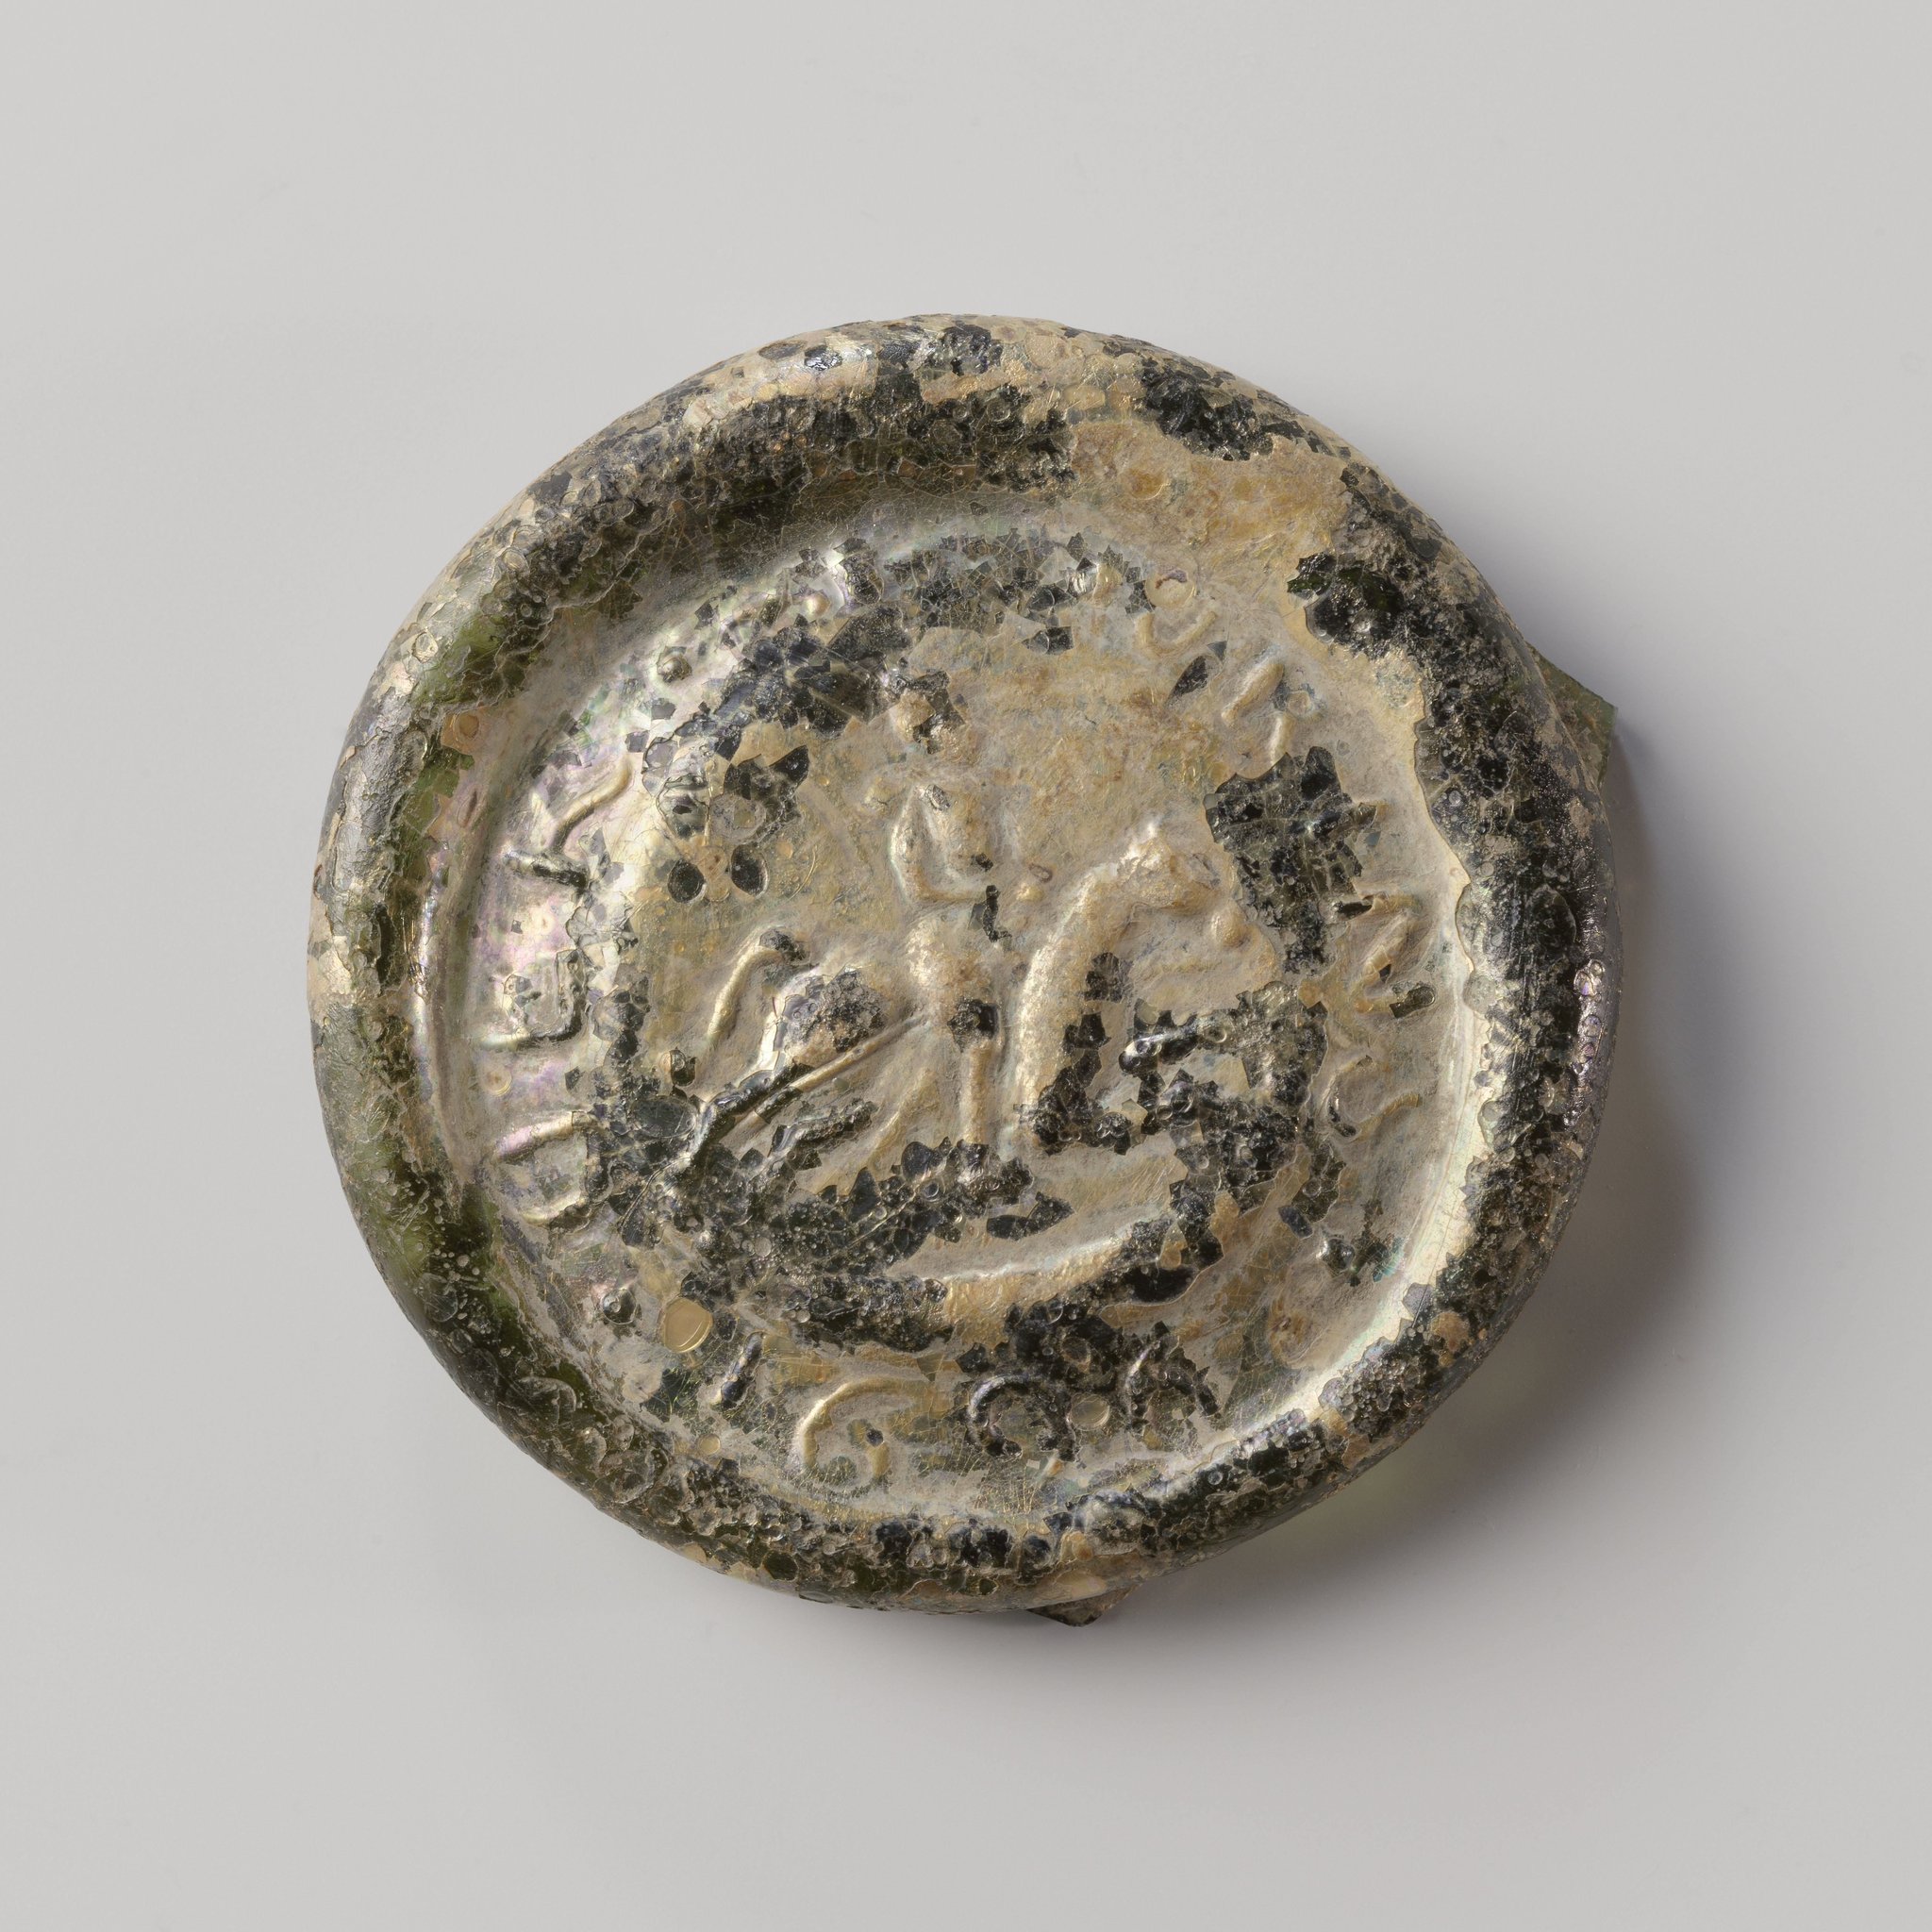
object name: glaszegel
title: Glaszegel van een fles met het ruiterportret van Willem III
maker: Anonymous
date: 1696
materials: glass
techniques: glassblowing, printing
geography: holstein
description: Orange souvenirs. William III's popularity, and later also that of his wife Mary, gave rise to a wide variety of objects sporting their pictures: medallions, glasses, tiles, cutlery and Delftware pottery.